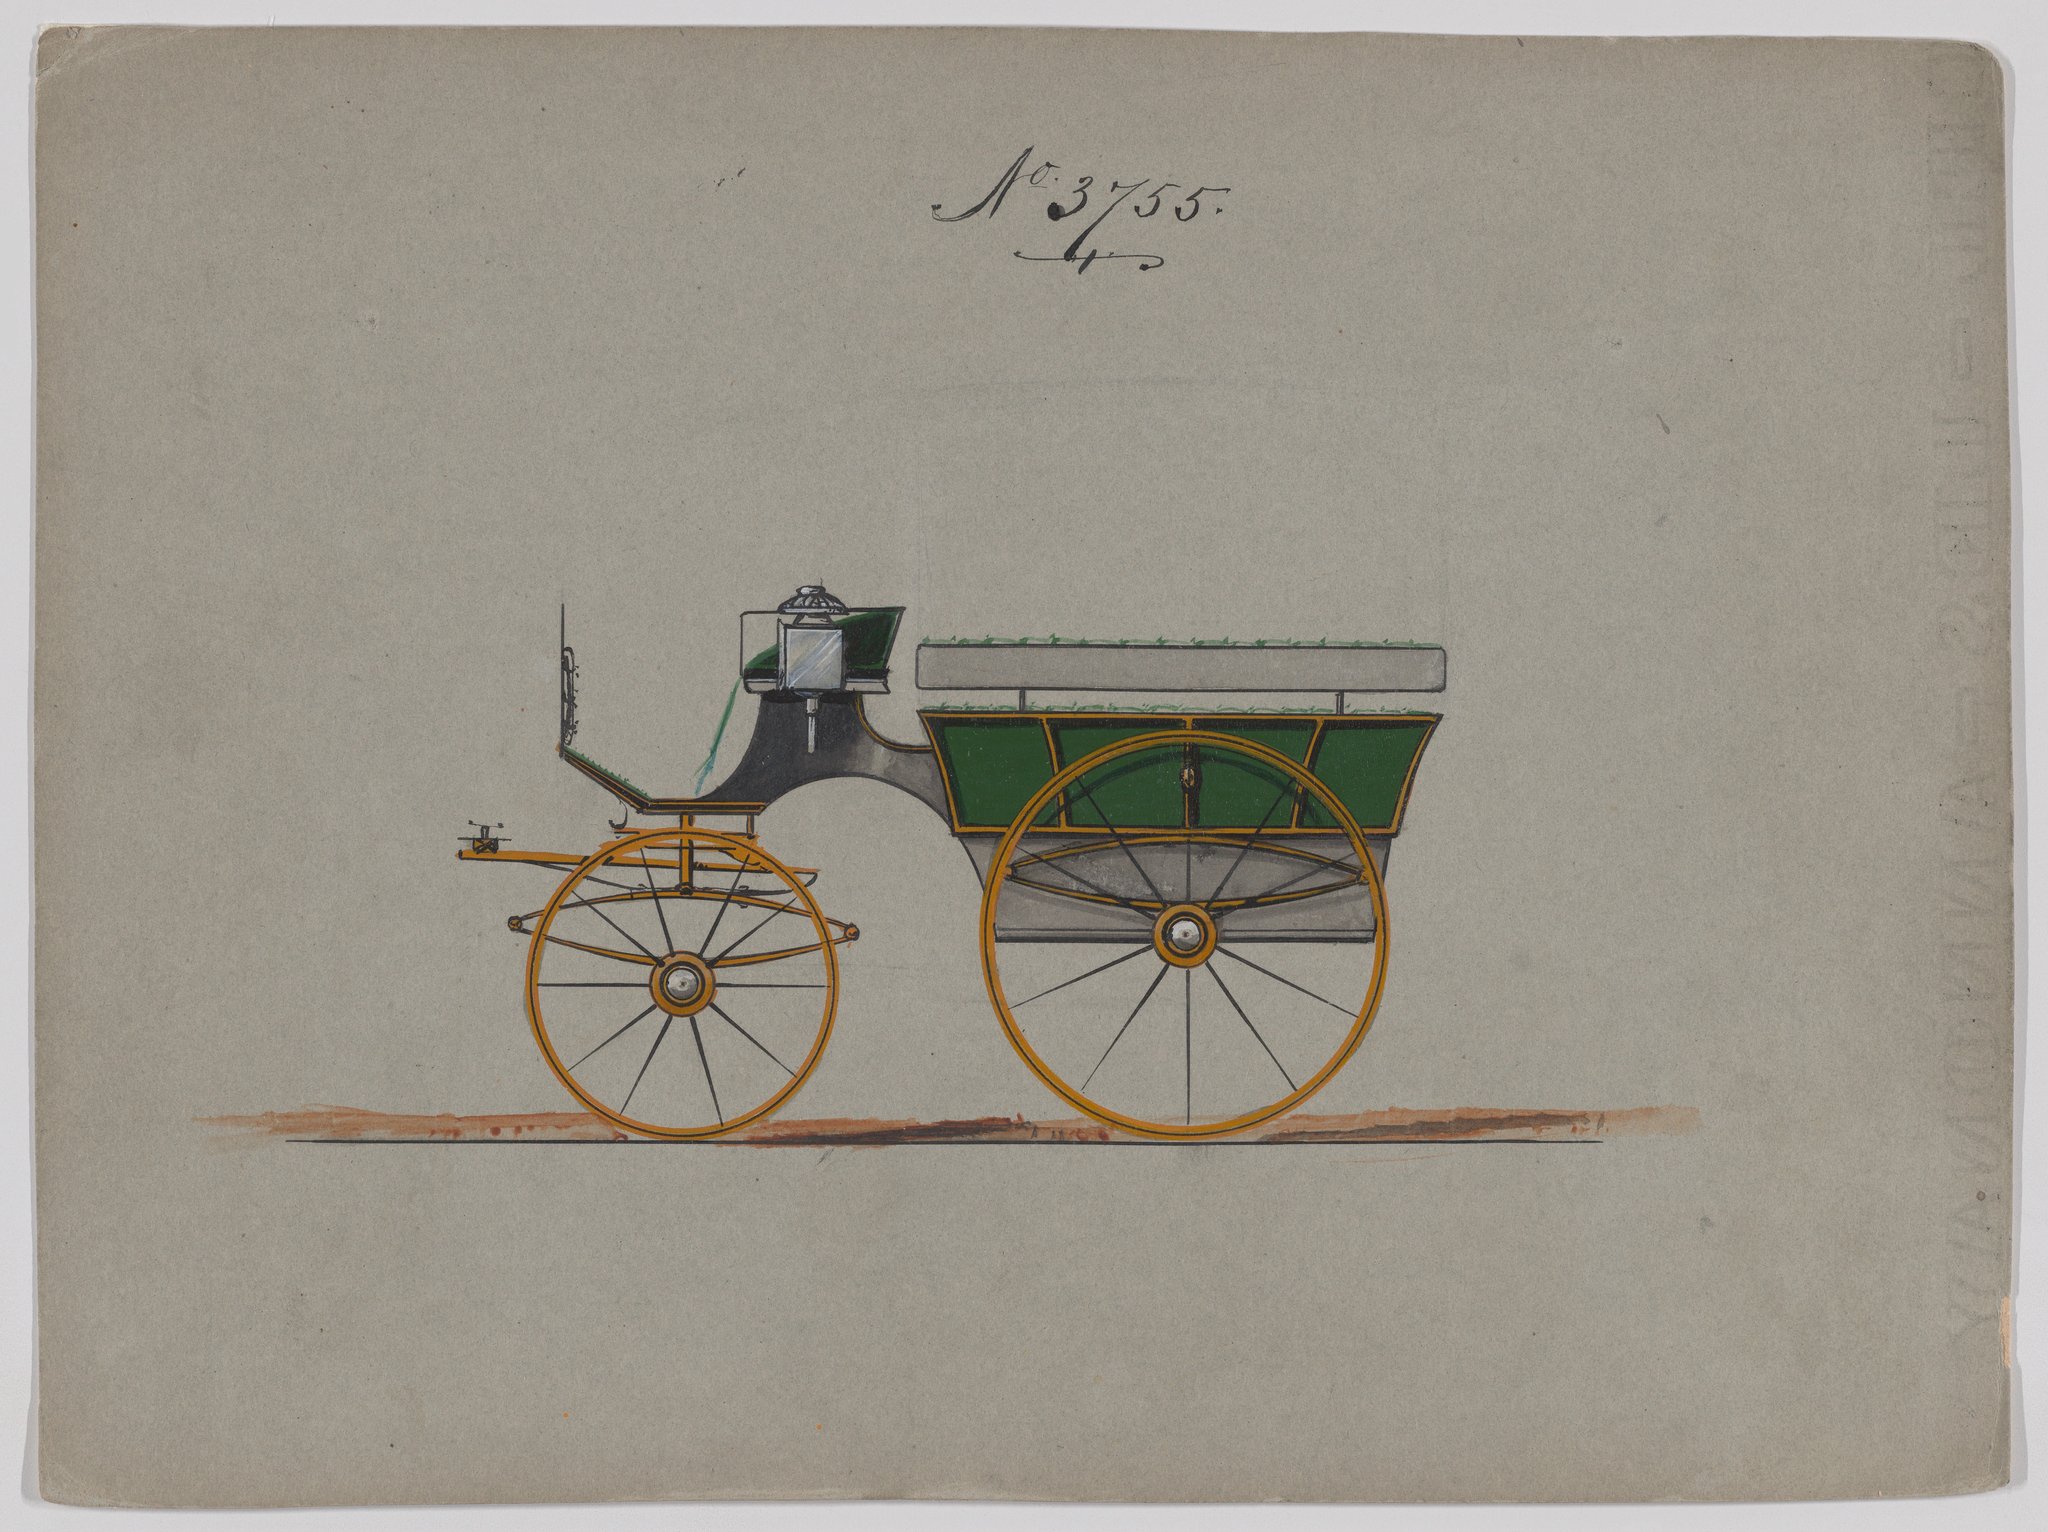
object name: drawing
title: Design for Omnibus or Wagonette, no. 3755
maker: brewster & co.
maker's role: manufacturer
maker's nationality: american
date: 1882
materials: gouache, graphite, gum arabic, ink, watercolor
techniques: pen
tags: carriages